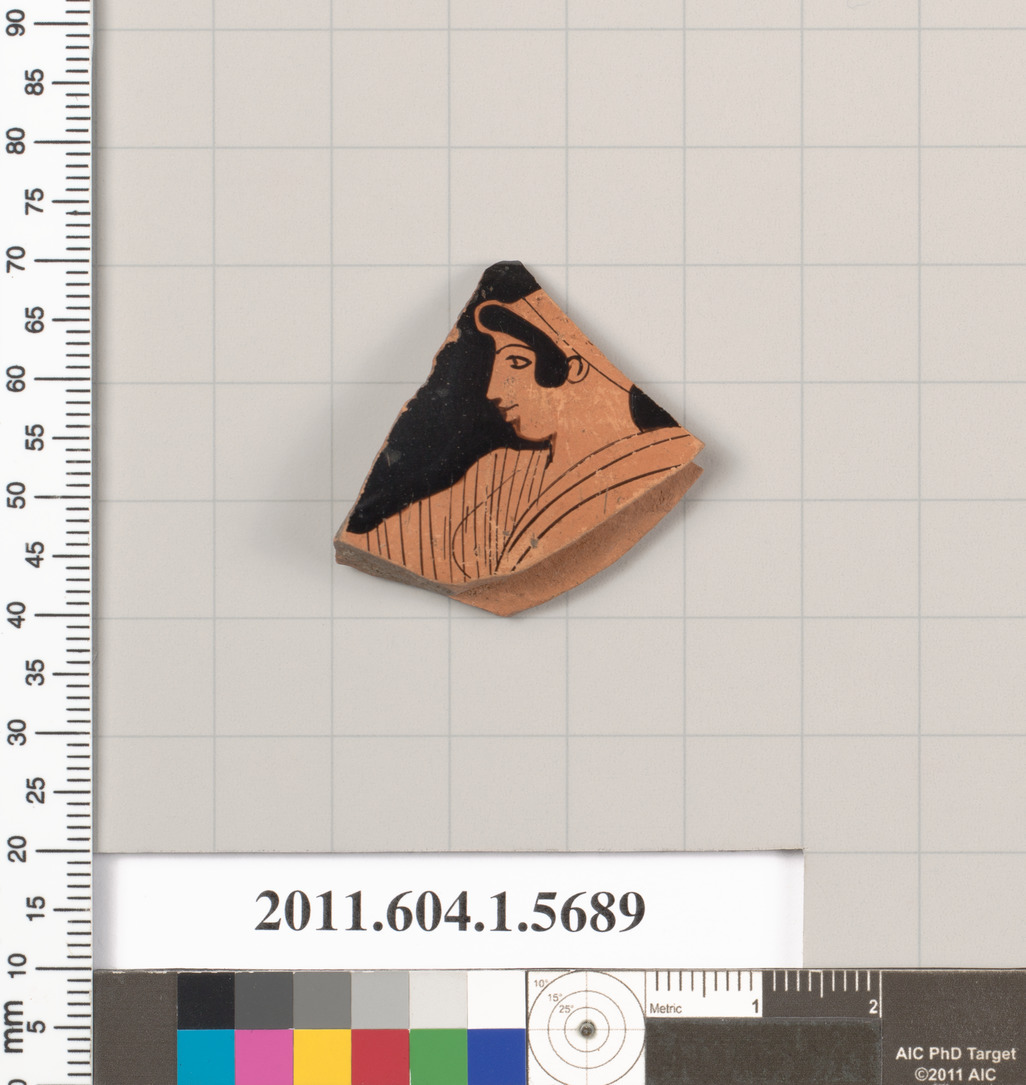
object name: kylix fragment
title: Terracotta fragment of a kylix (drinking cup)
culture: greek, attic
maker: aischines painter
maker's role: artist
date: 475-451 BCE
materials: terracotta